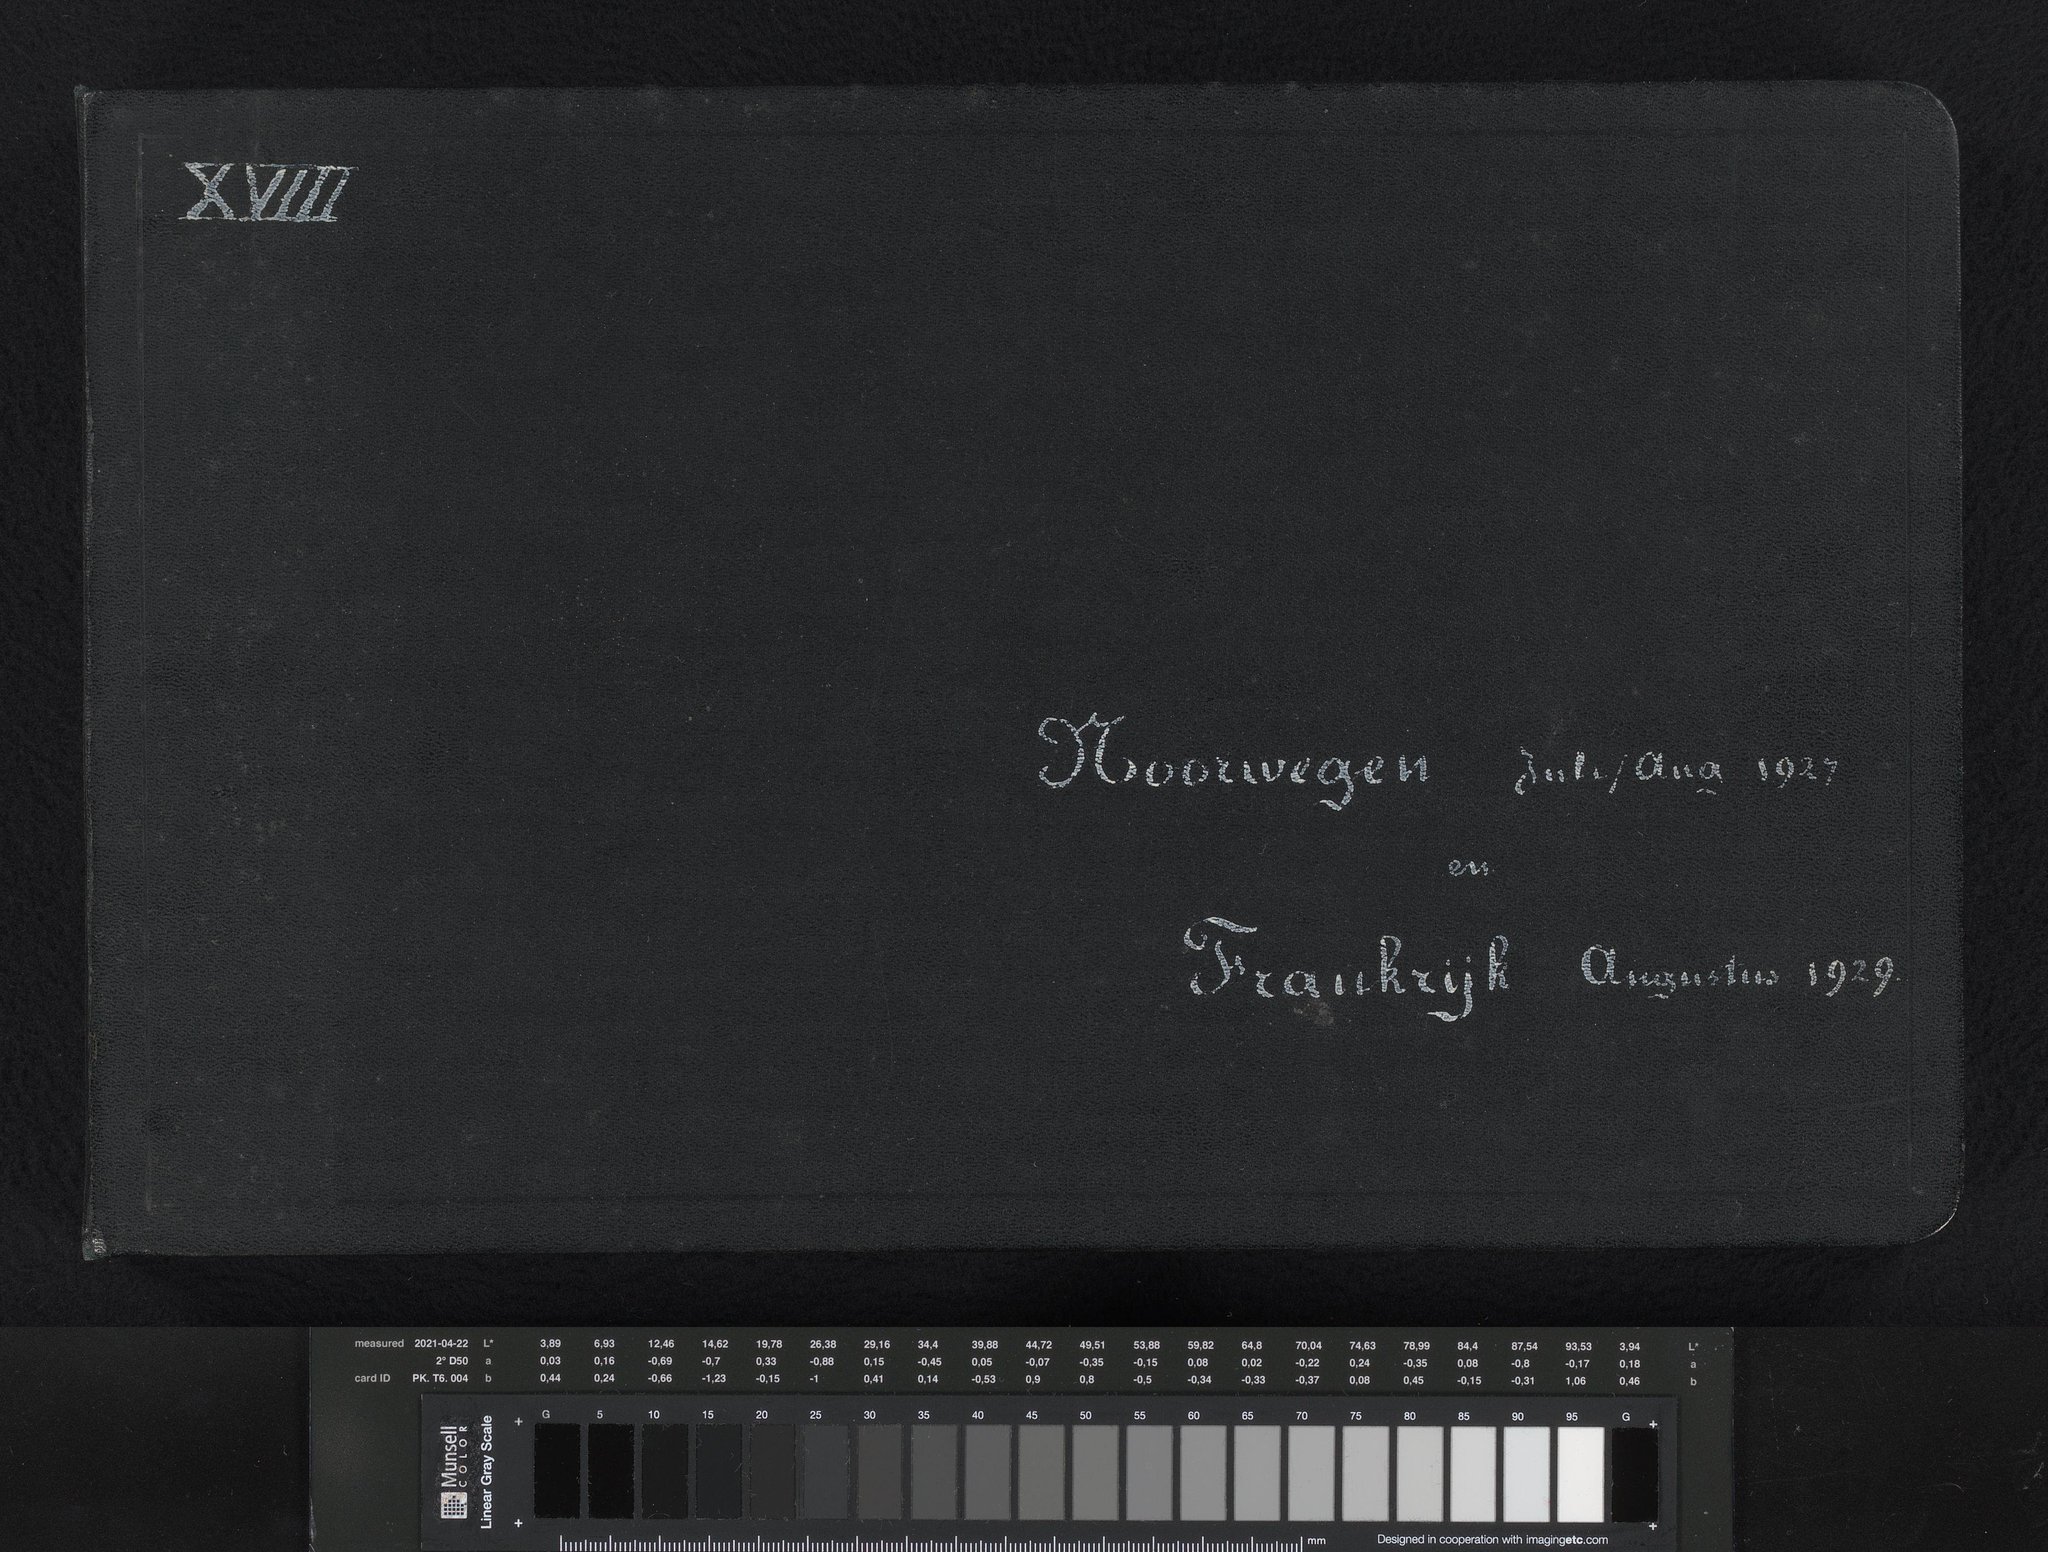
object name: scrapbook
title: Fotoalbum van vakanties in Noorwegen en in Frankrijk van de familie van Hendrik Herman van den Berg, 1927-1929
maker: hendrik herman van den berg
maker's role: amateurfotograaf, jurist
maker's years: 1875-1944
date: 1927-1929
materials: paper, cardboard, leather, ink, metal, textile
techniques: photograph, gelatin silver print, moire, pen, photoaquatint, rotogravure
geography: the hague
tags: the family travelling, on holiday, france, norway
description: Plakboek met 323 foto's en 84 fotomechanische afdrukken, verdeeld over 107 pagina's. Het album bevat een combinatie van foto's genomen door Hendrik Herman van den Berg en fotografische respectievelijk fotomechanische prentbriefkaarten die ter plekke zijn gekocht. Men ziet een vakantie naar Noorwegen in 1927 en een vakantie naar Frankrijk in 1929. De eerste 35 pagina's bevatten handgeschreven bijschriften.